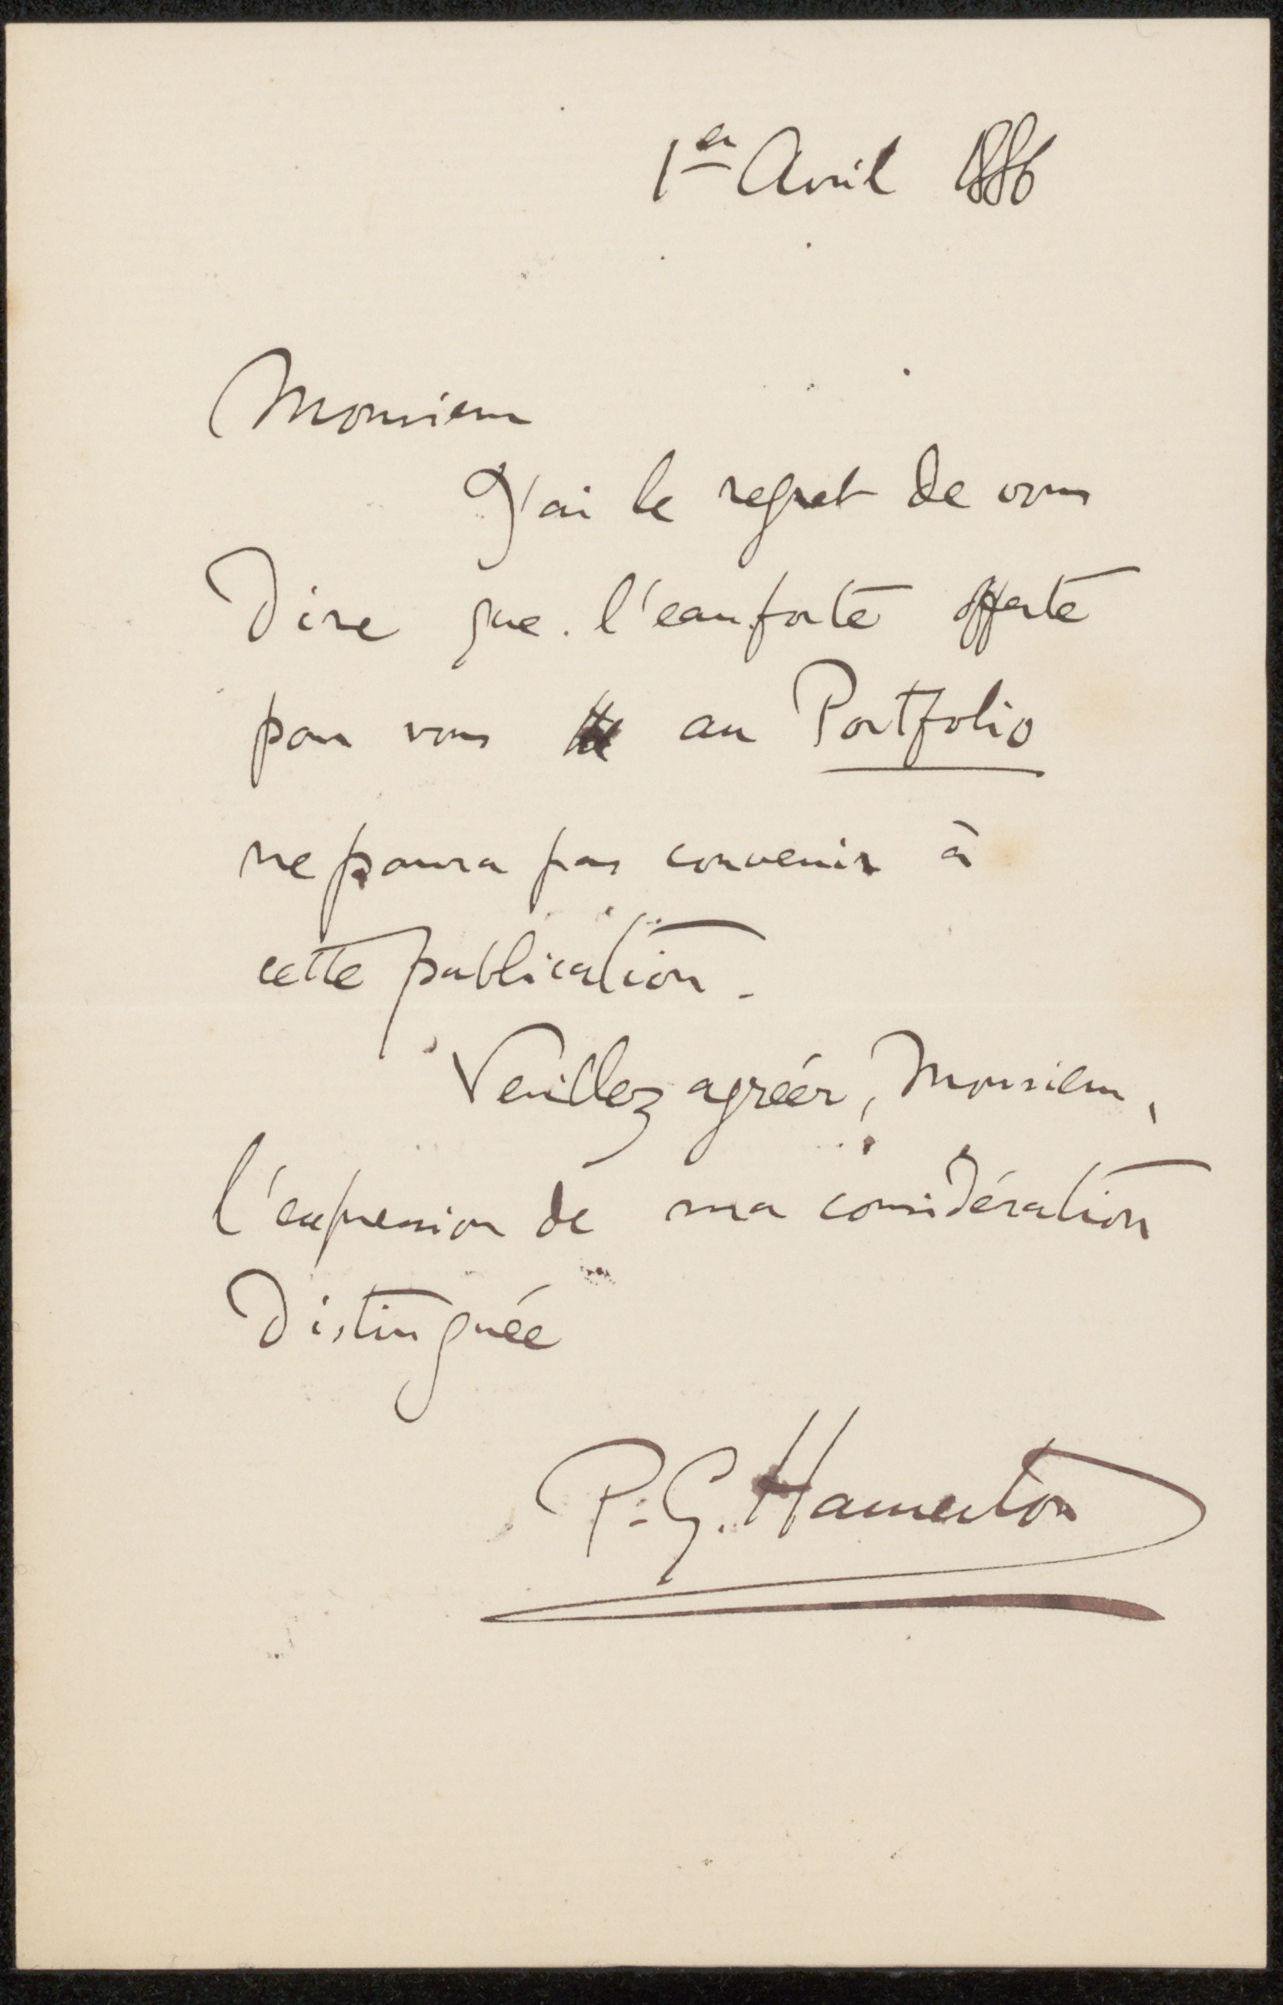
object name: letter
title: Brief aan Philip Zilcken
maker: philip gilbert hamerton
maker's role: print maker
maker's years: 1834-1894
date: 1886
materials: ink, paper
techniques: pen, writing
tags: painter, draughtsman, philip zilcken, the graphic arts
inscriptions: collector's mark: ‘RPK’